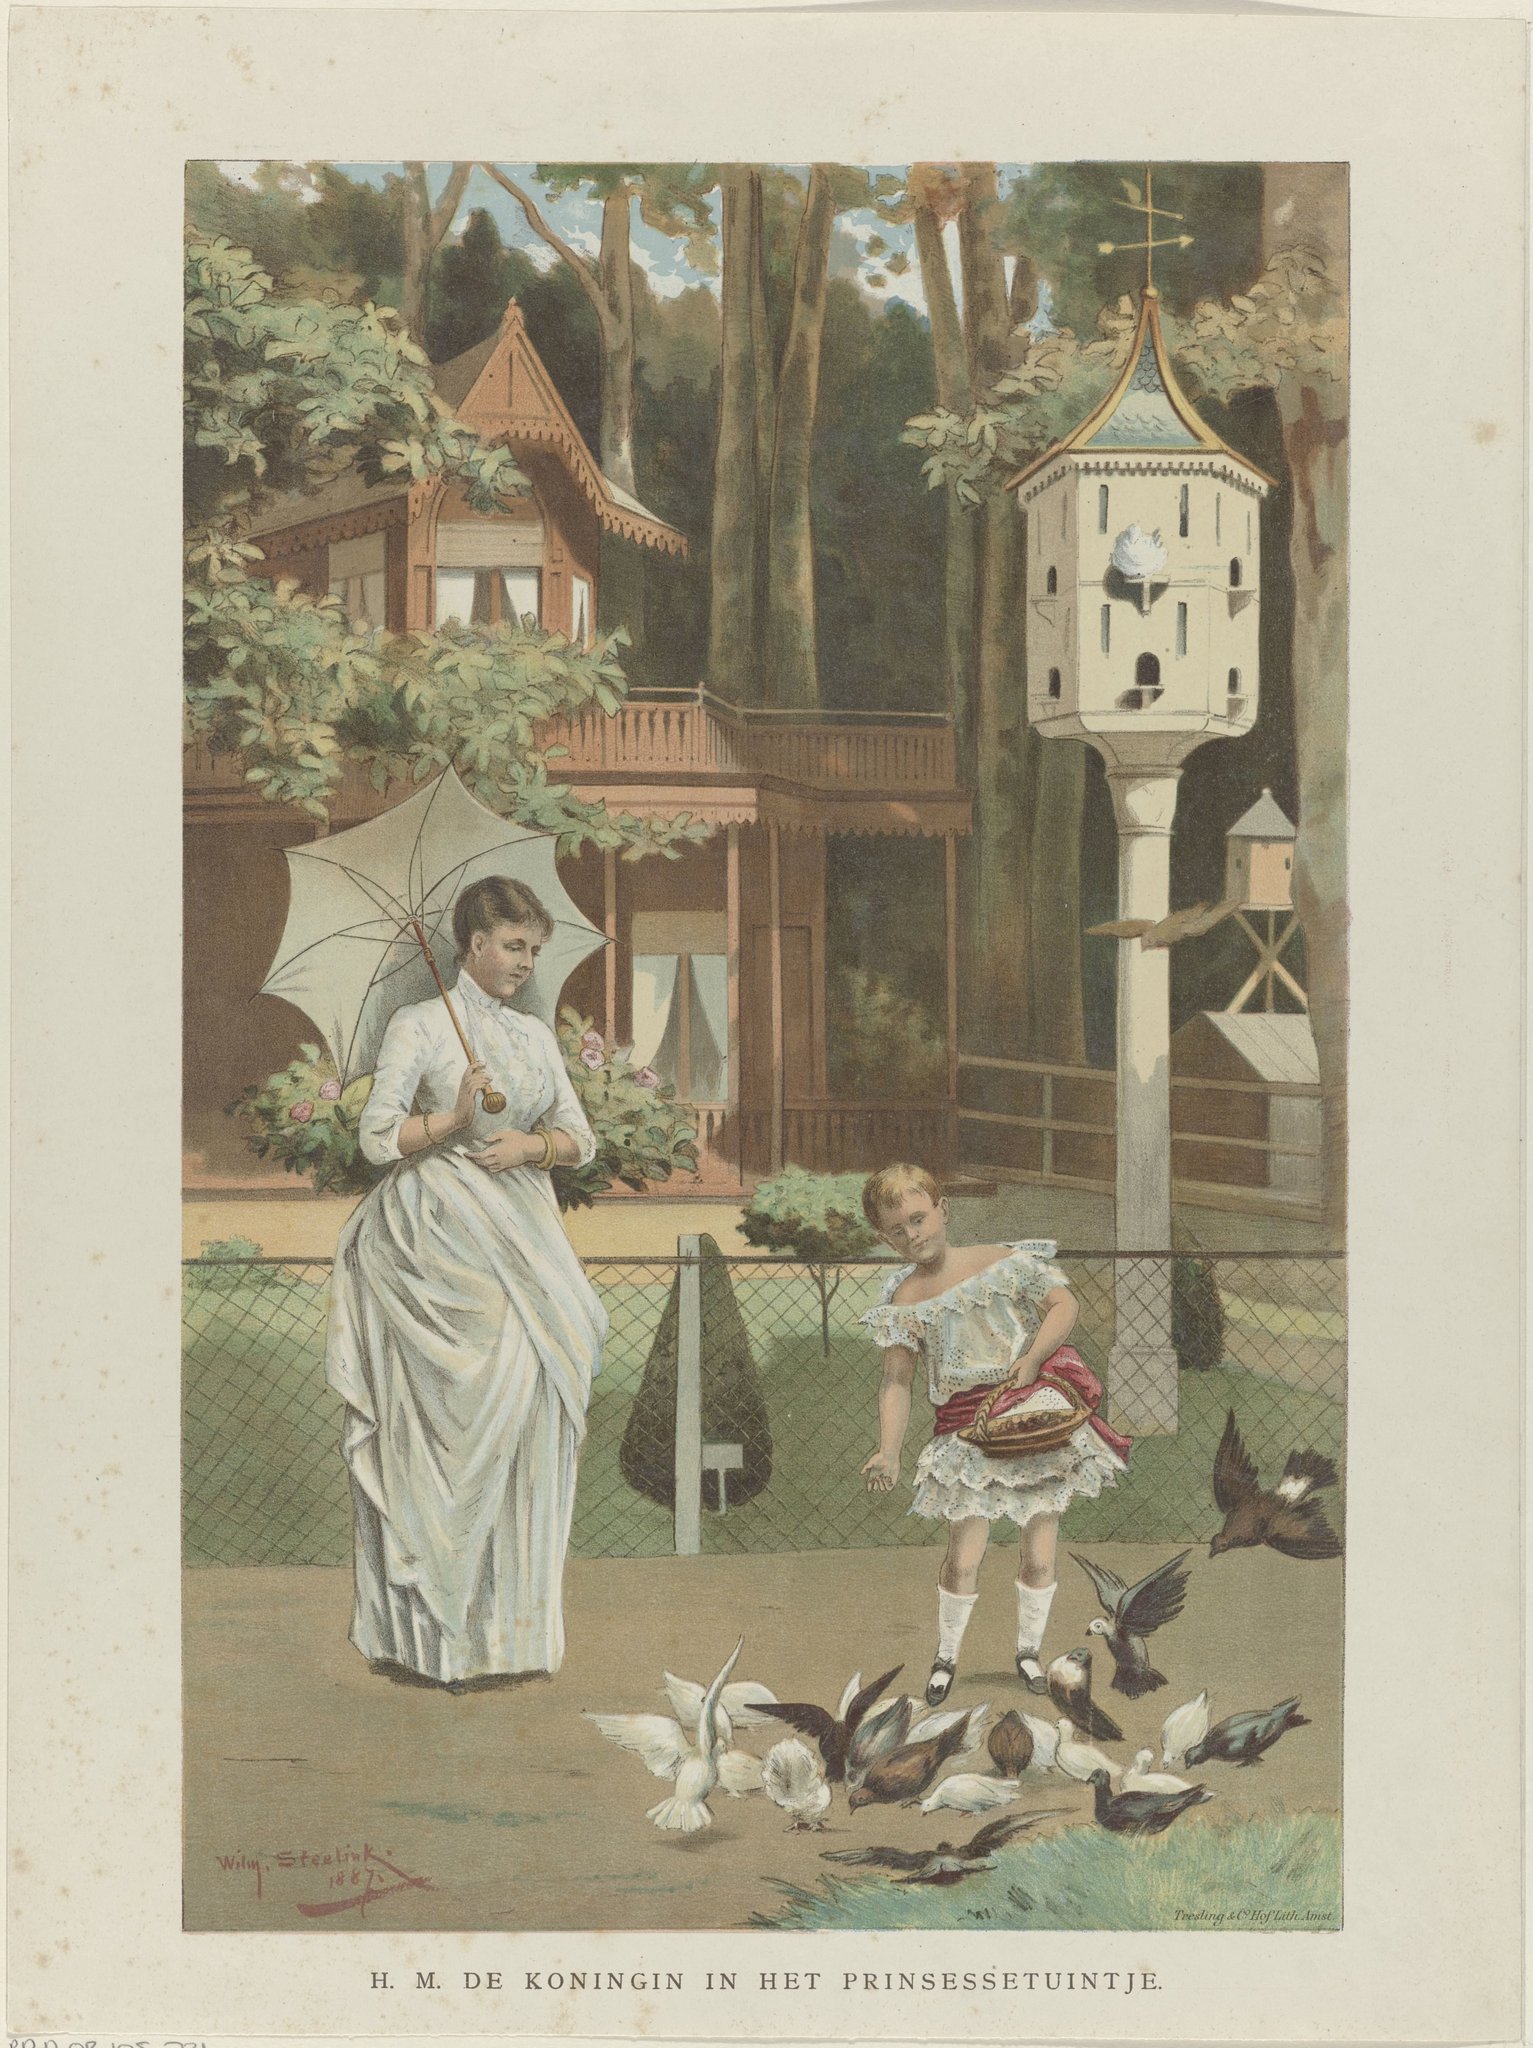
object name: print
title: Portret van Emma, koningin-regentes der Nederlanden, en Wilhelmina, koningin der Nederlanden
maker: willem steelink (ii)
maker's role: draughtsman, print maker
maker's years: 1856-1928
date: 1887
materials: paper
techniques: lithograph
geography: netherlands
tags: the hague, print maker, wilhelmina of the netherlands, emma (queen consort of the netherlands)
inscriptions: date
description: Portret van Emma en Wilhelmina. Emma heeft in haar rechterhand een parasol en Wilhelmina voert vogels in het Prinsessentuintje van Paleis Noordeinde te Den Haag. In de ondermarge een regel Nederlandse tekst.